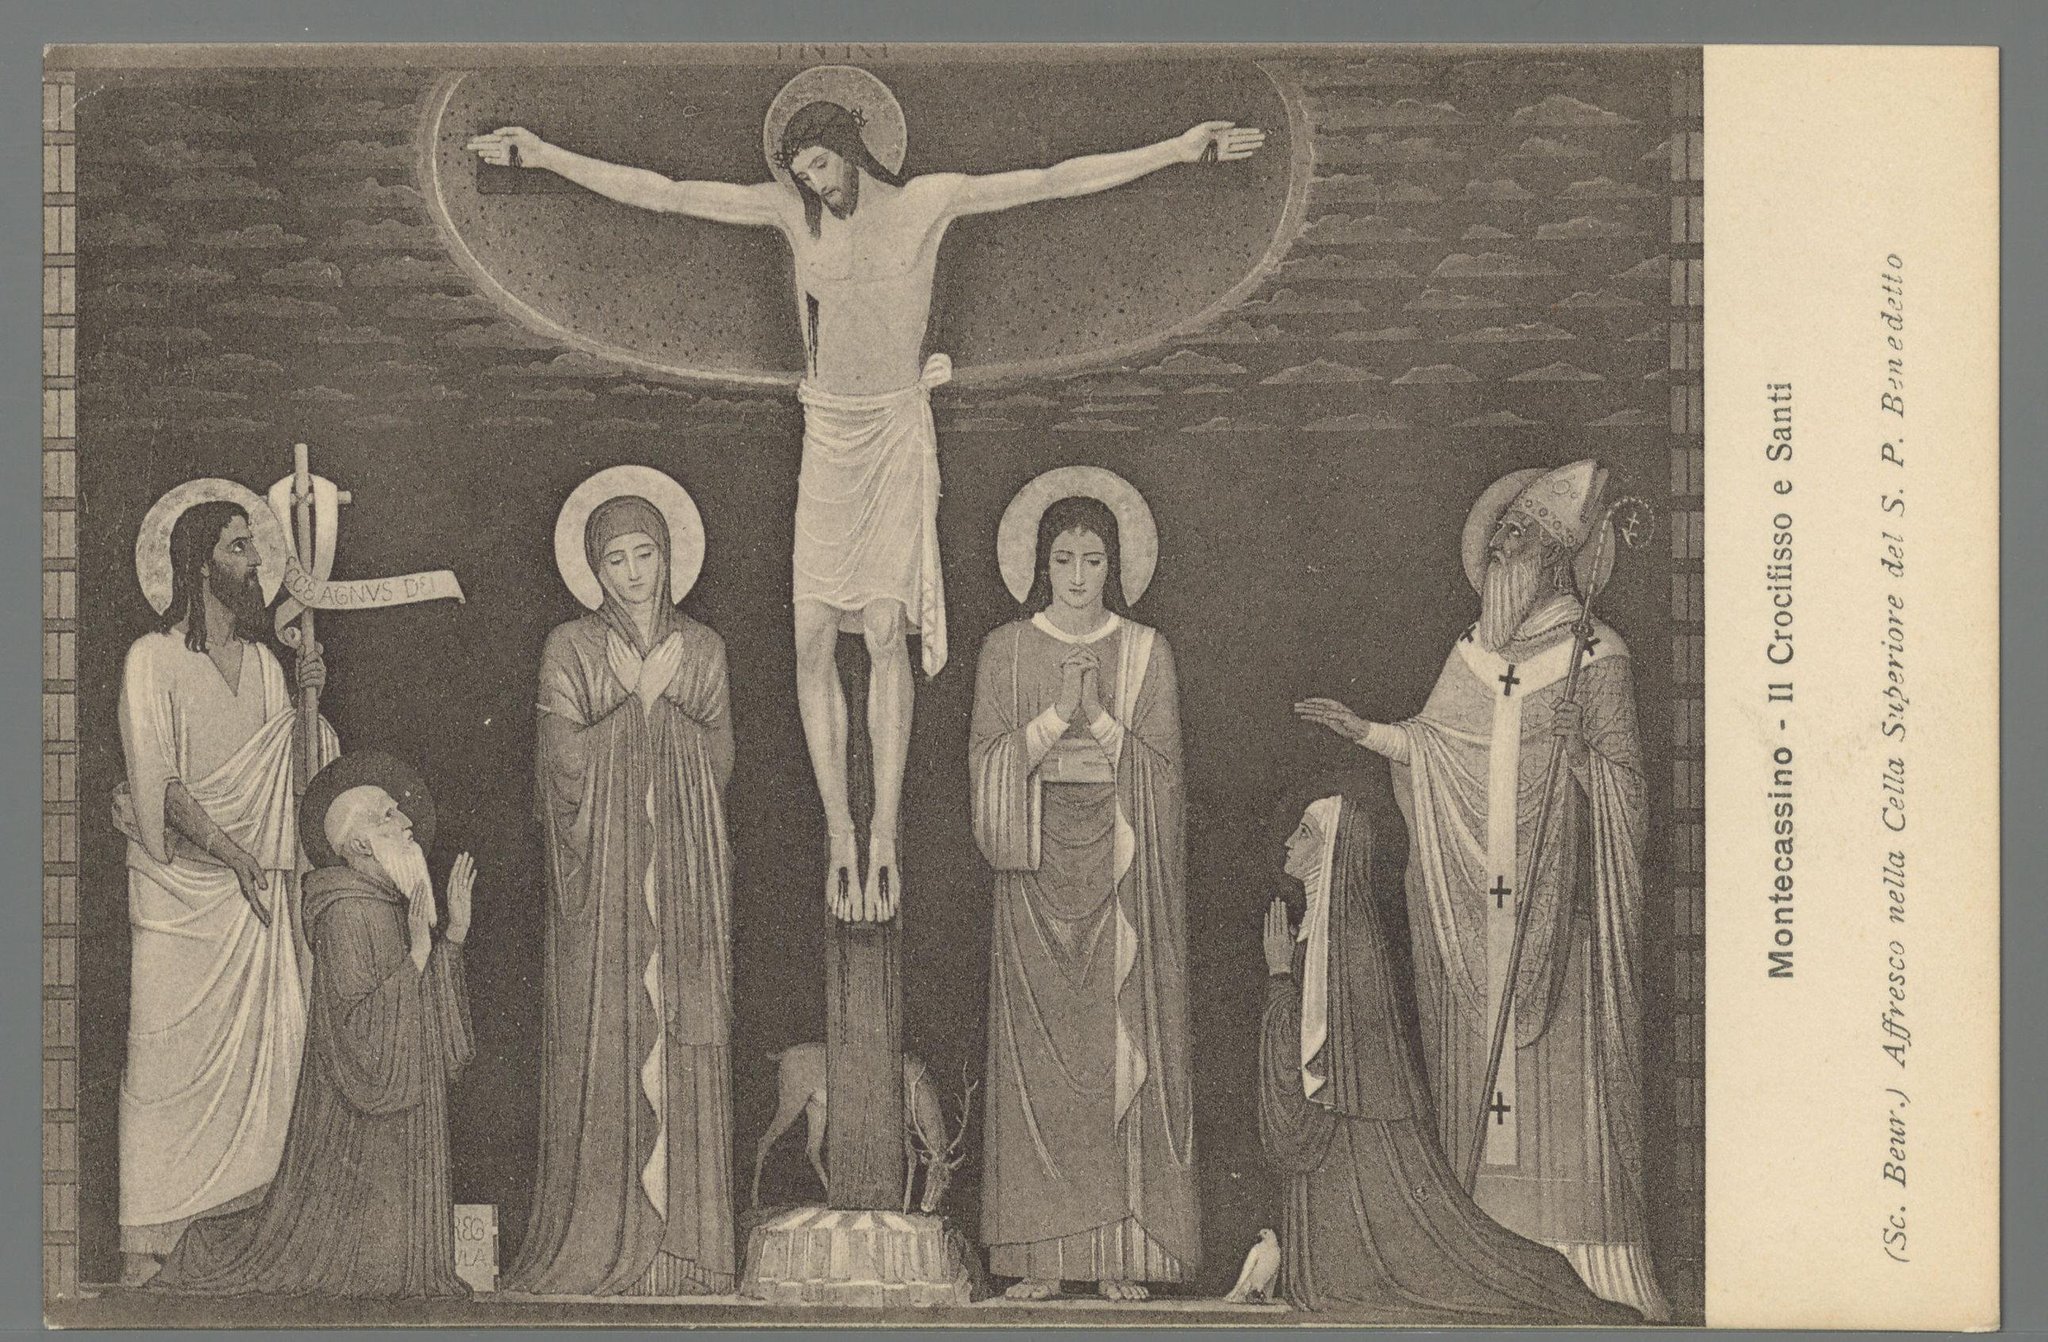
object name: photomechanical print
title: Montecassino. Il Crocifisso et Santi.Benedetto. (Sc. Beur.) Affresco nella Cappella Superiore del S.P. Benedetto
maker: Anonymous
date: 1906-1910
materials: cardboard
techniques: photograph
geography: terni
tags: interior of church, picture, painting